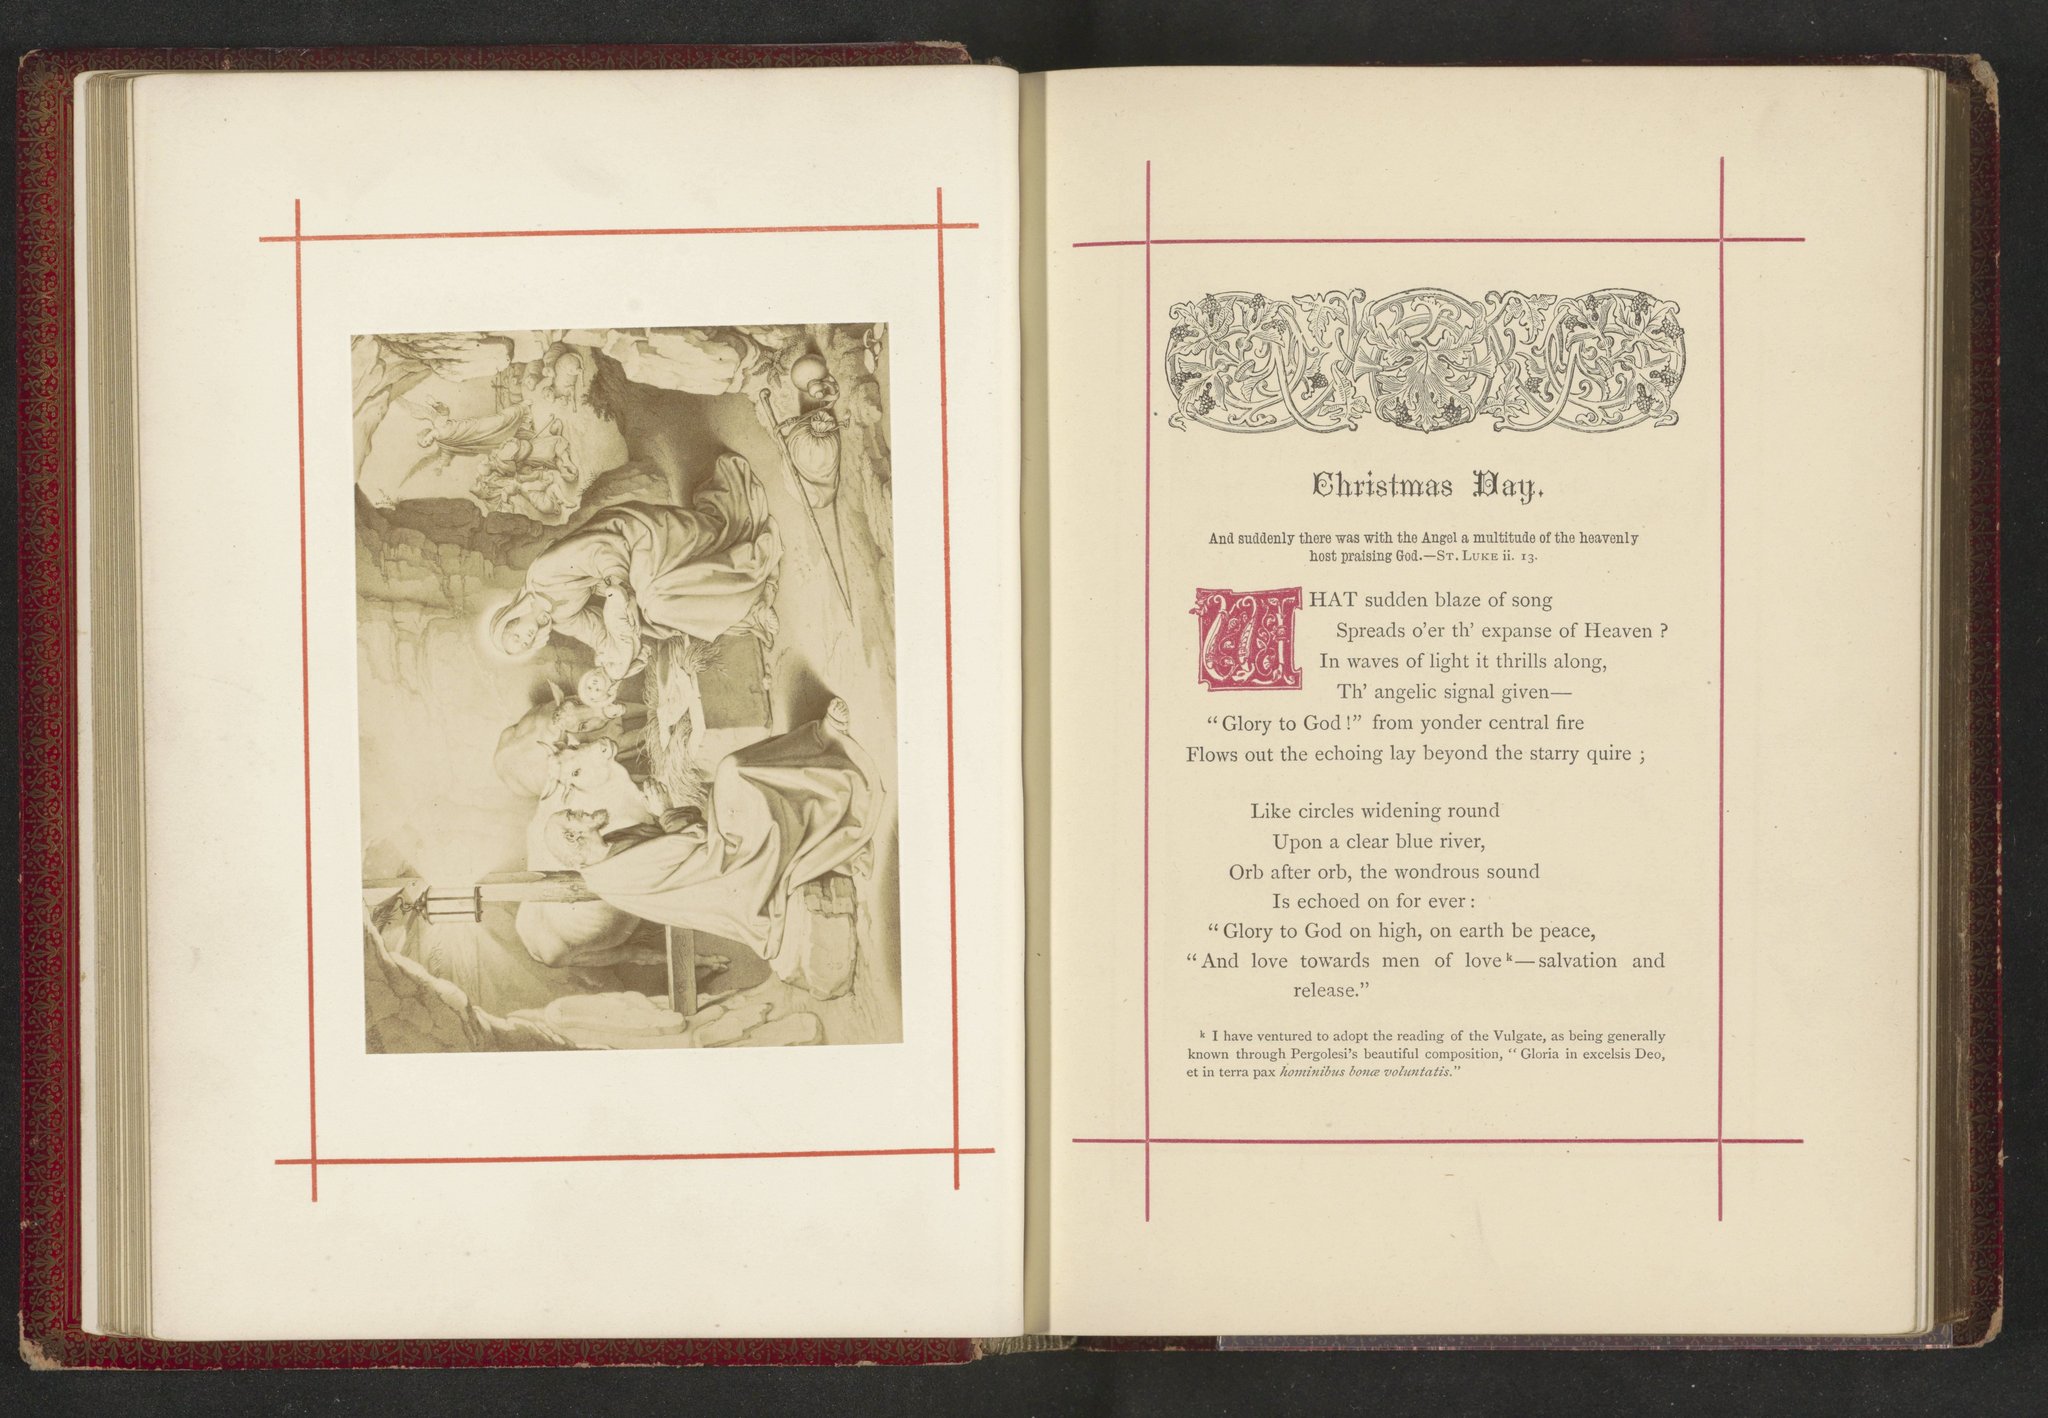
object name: page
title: Fotoreproductie van een prent, voorstellende de geboorte van Christus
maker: Anonymous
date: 1868-1873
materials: photographic support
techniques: albumen print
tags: adoration of the christ-child ~ christ's birth